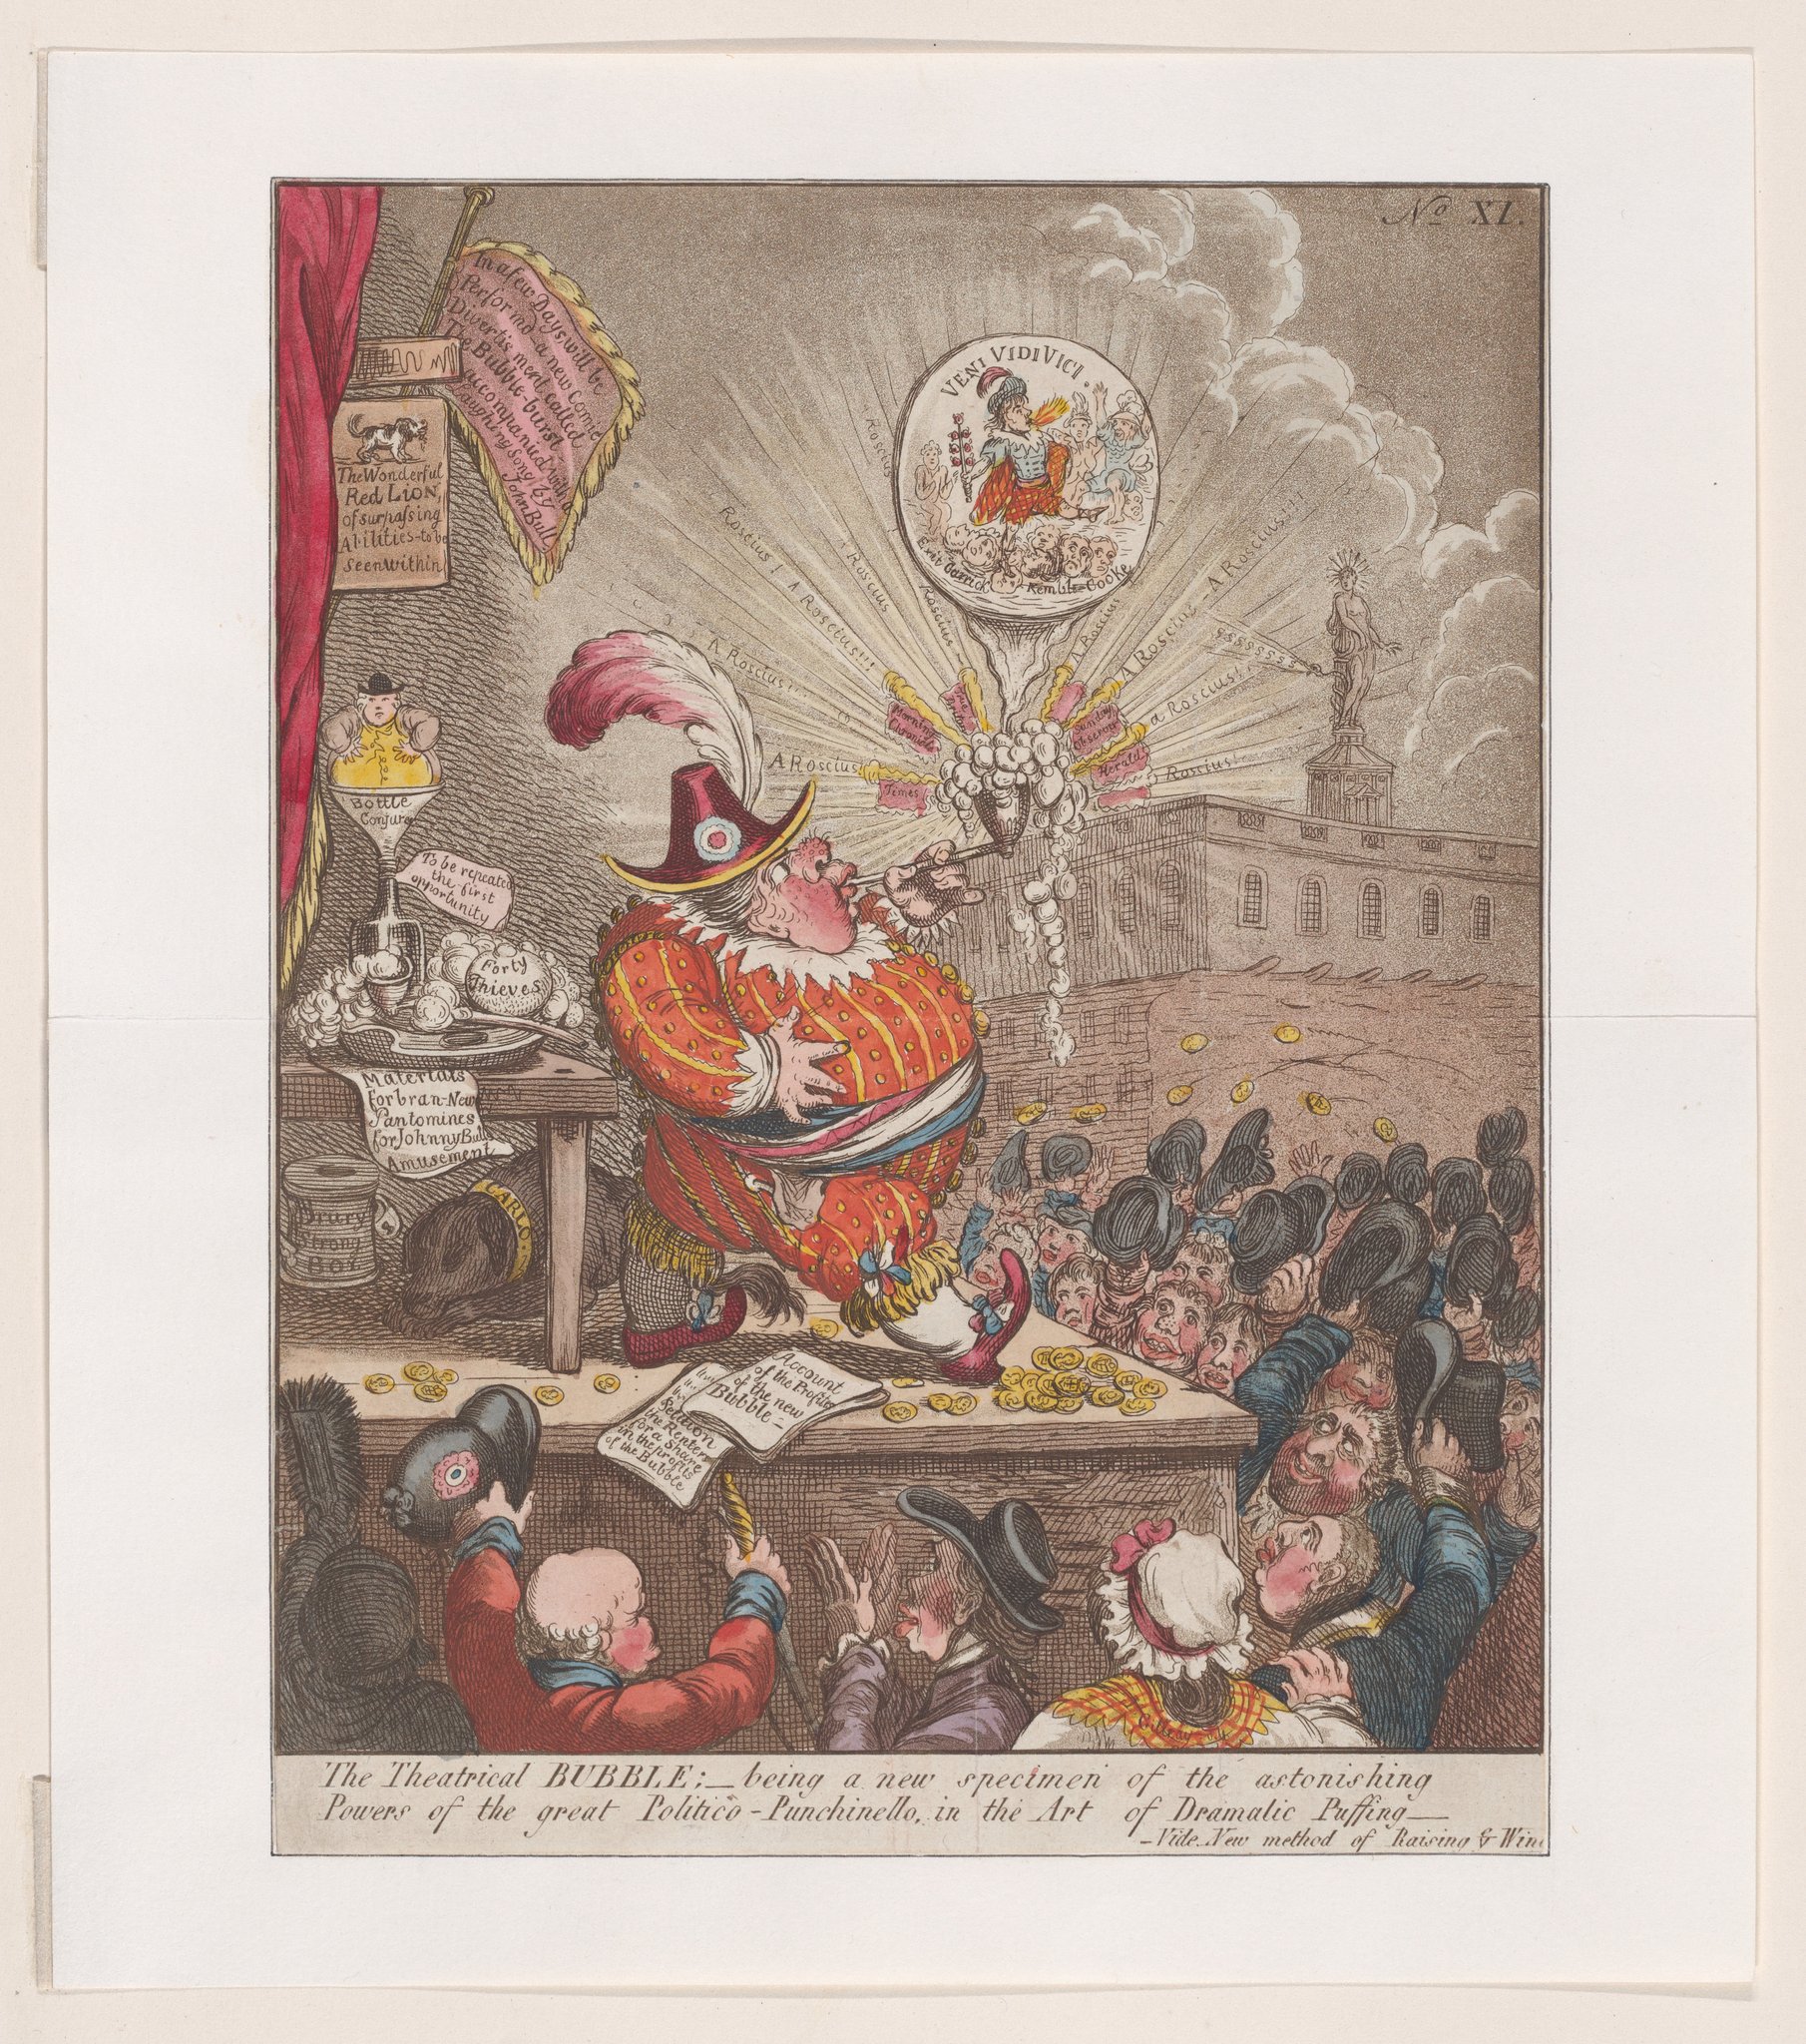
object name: print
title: The Theatrical Bubble; being a new Specimen of the Astonishing Powers of the Great Politiico-Punchinello in the Art of Dramatic Puffing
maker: james gillray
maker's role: artist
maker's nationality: british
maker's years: 1756-1815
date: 1805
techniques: etching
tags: men,bubbles,caricature,pipes